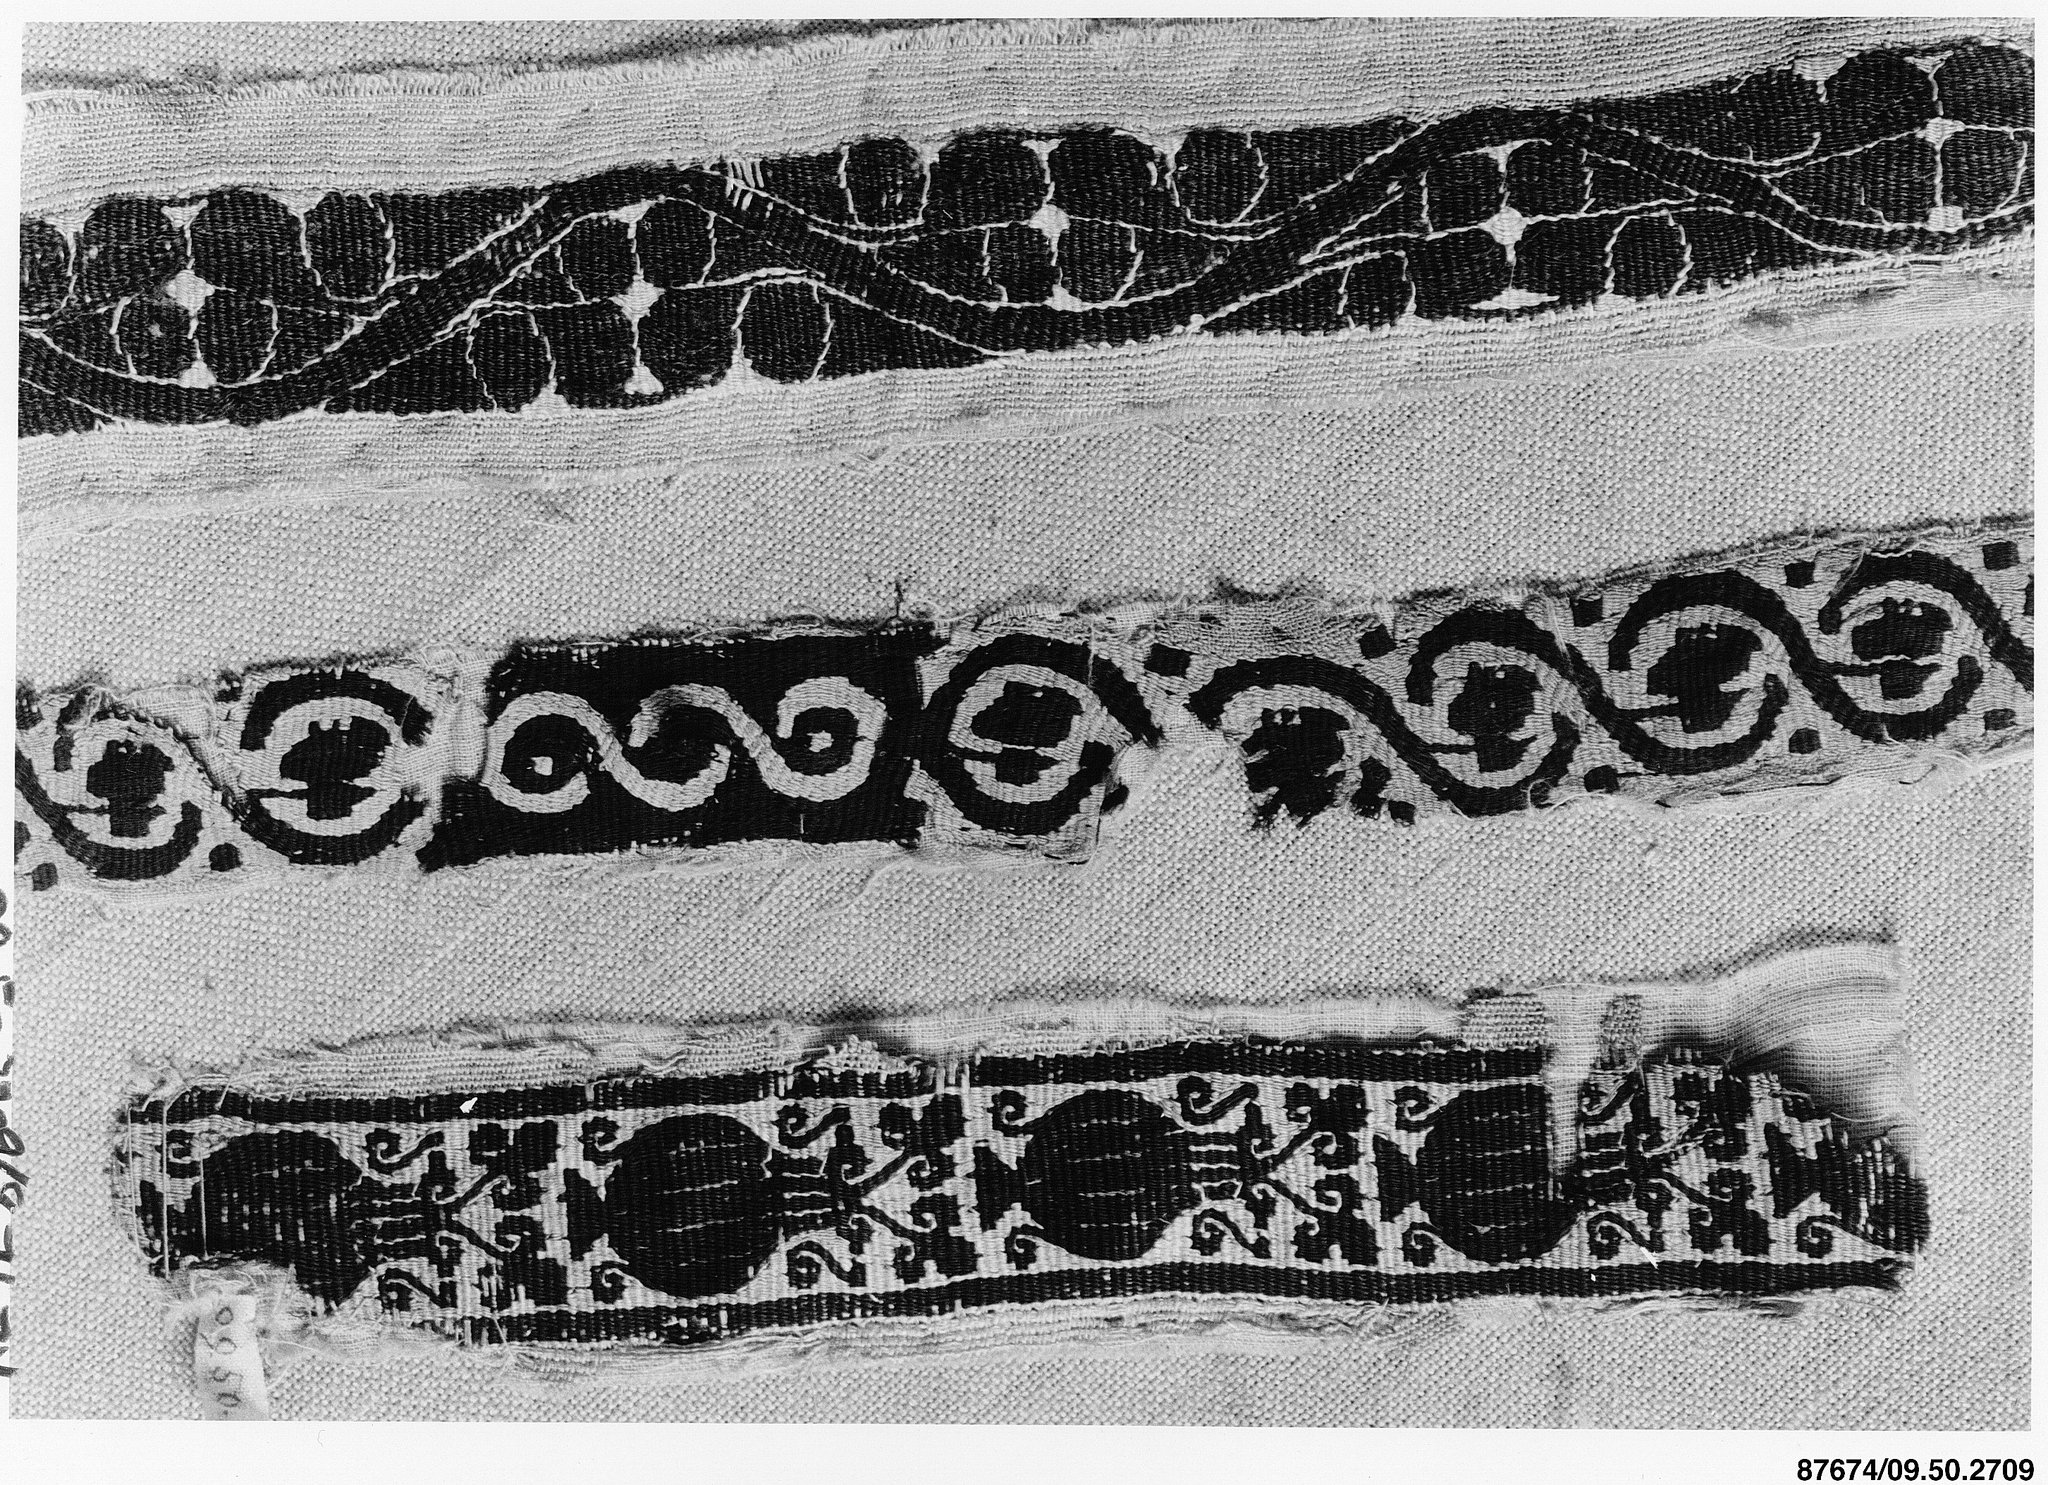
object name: shoulder band fragment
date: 301-500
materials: linen, wool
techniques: weave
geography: egypt